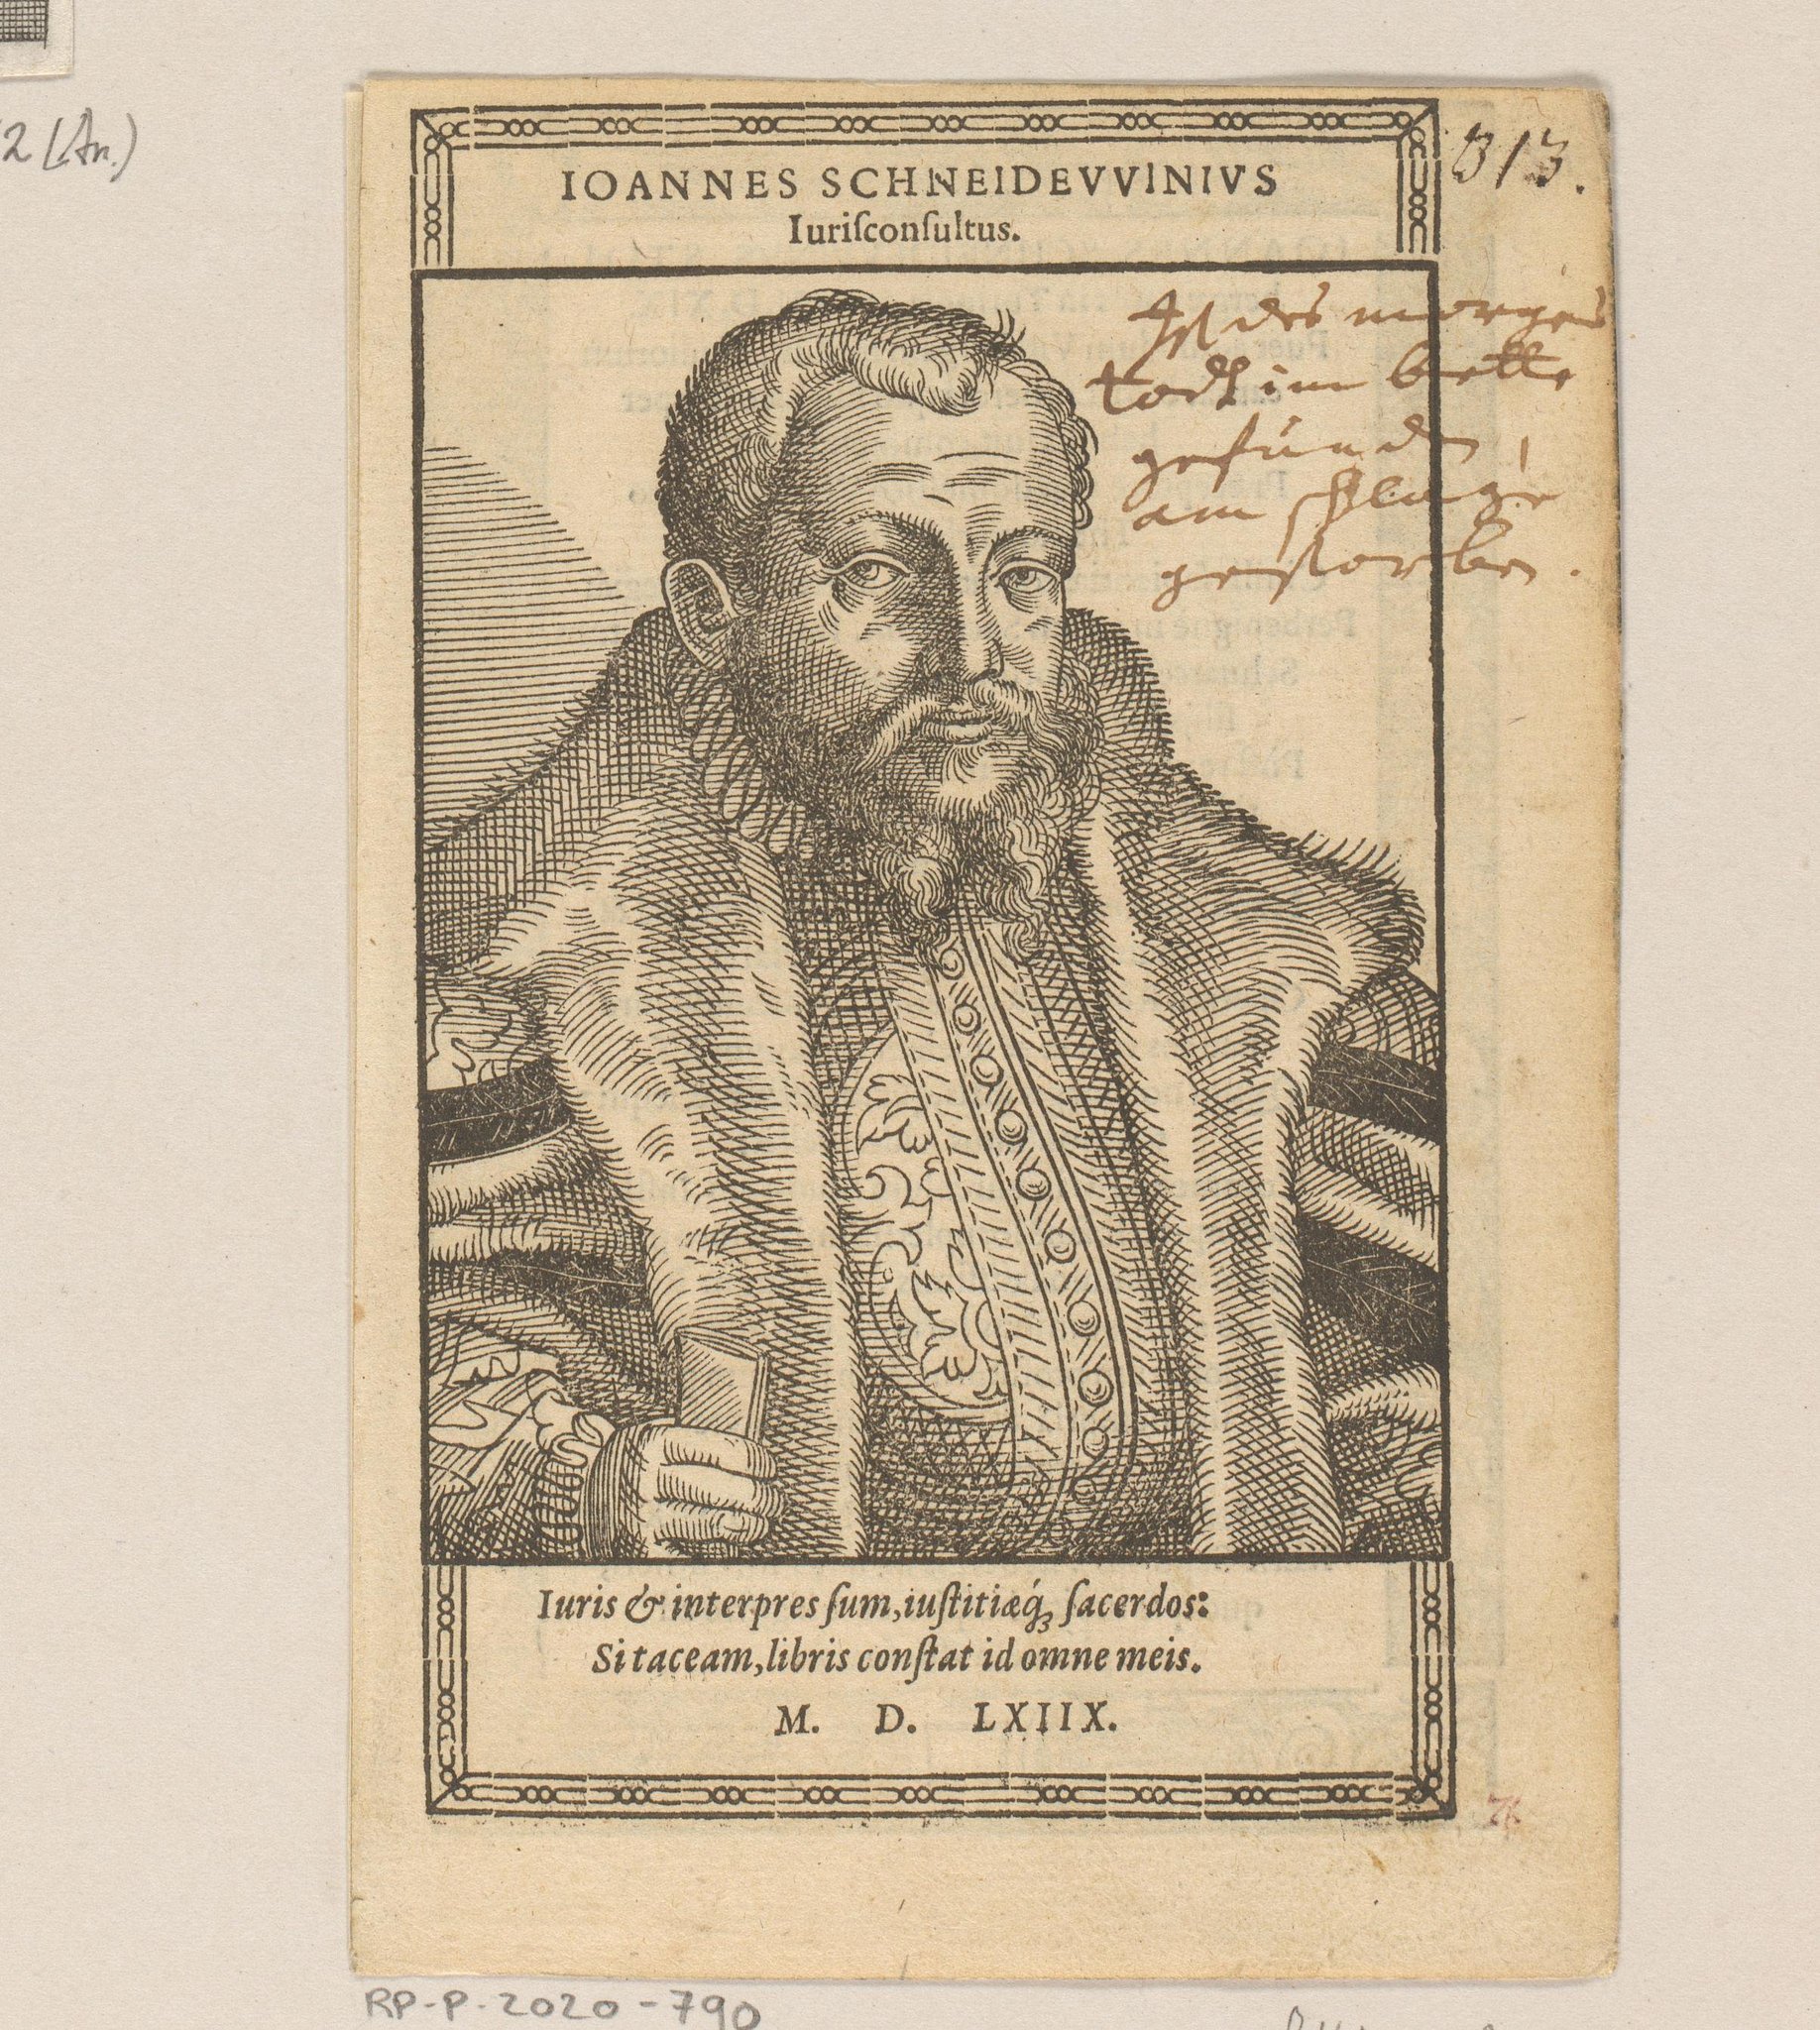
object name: print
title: Portret van Johann Schneidewein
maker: bernhard jobin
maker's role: printer, publisher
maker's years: 1545-1593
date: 1587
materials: paper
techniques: letterpress printing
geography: straatsburg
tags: historical persons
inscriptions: inscription: ‘[...]’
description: Prent uit: Reusner, Nikolaus. Icones sive imagines virorum literis illustrium (...). Straatsburg: Bernhard Jobin, 1587. Prent ook gebruikt in de Duitse editie, uitgegeven in hetzelfde jaar, en de 1590-editie. Prent ook gebruikt in latere publicaties.